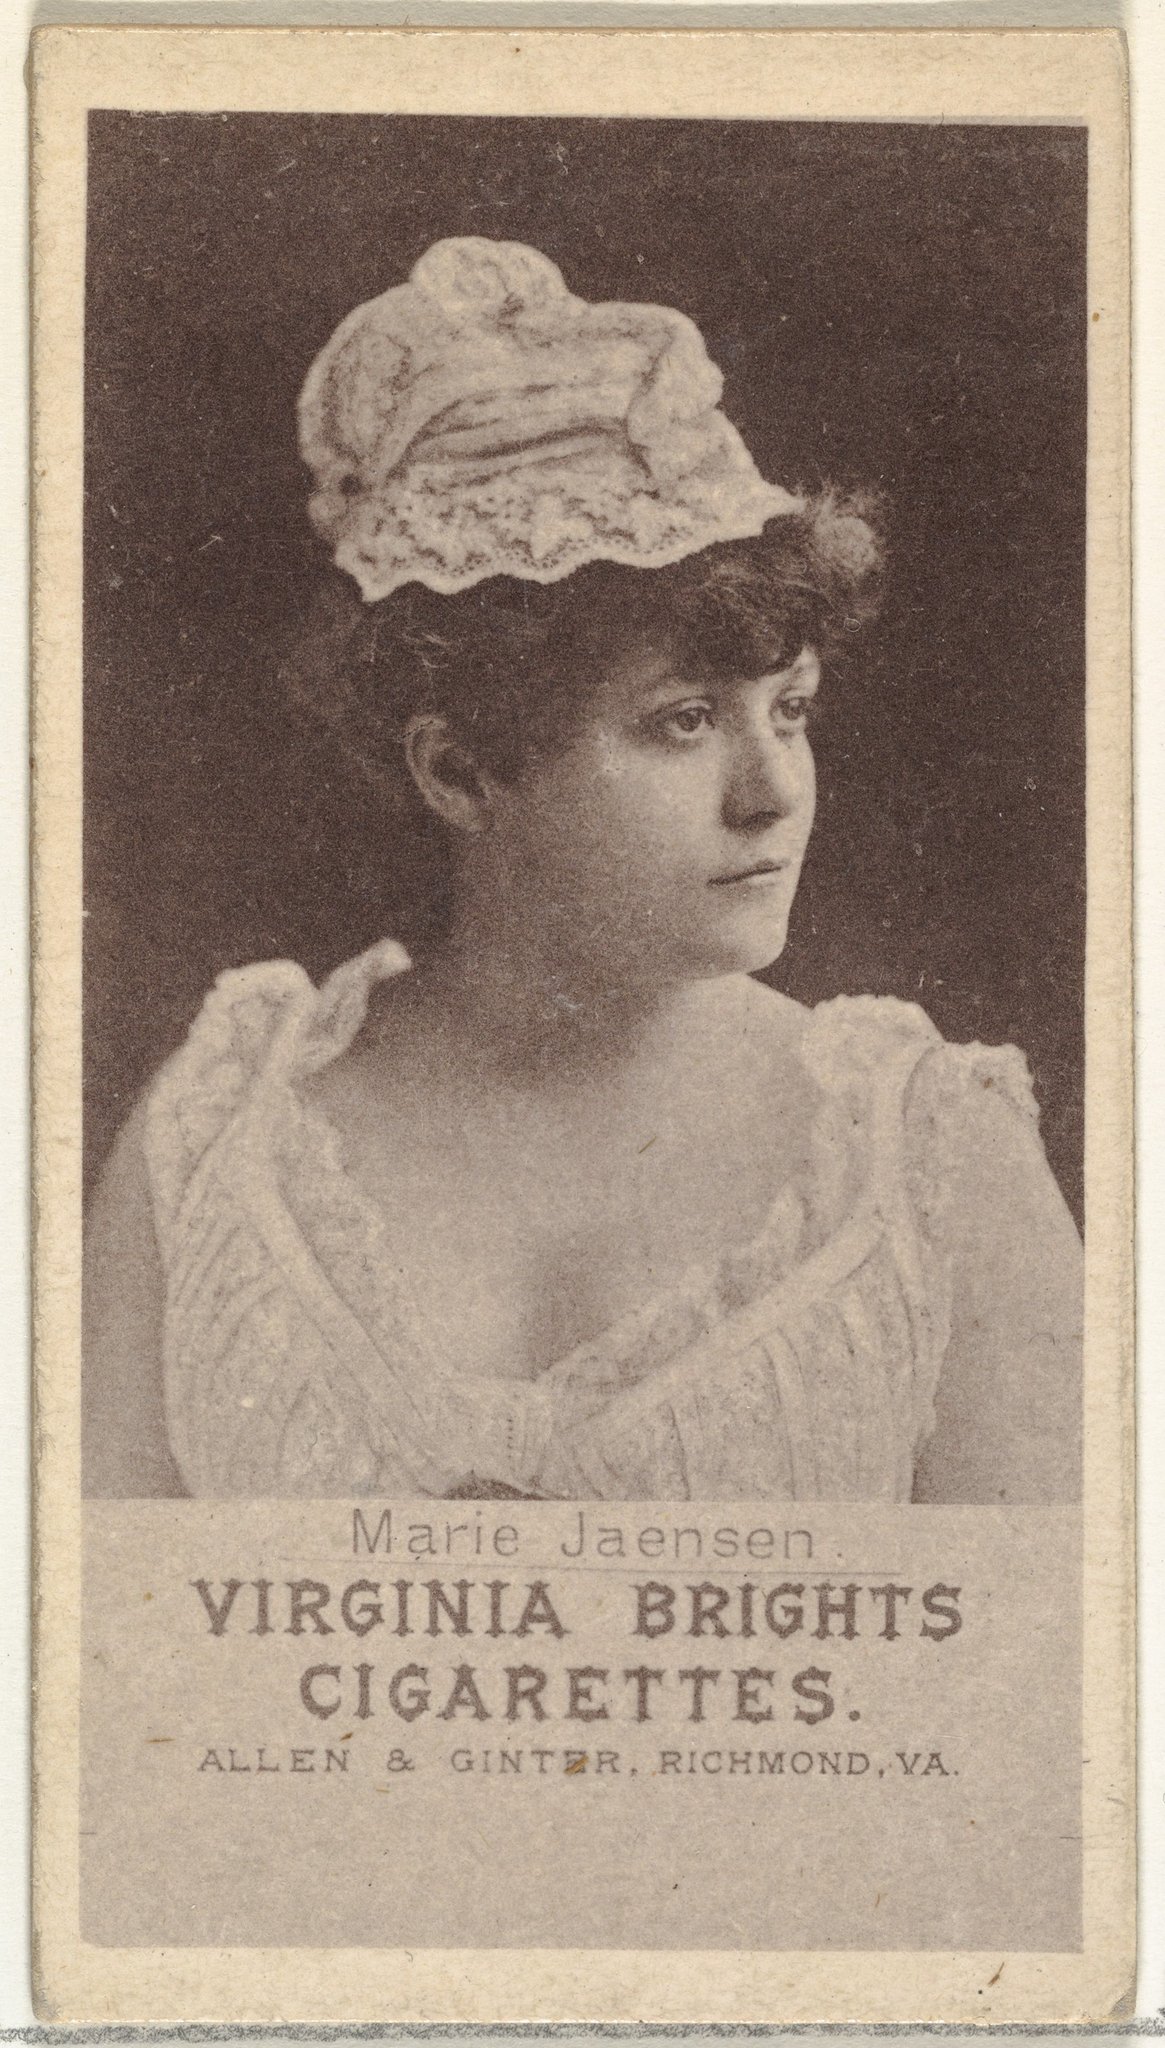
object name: print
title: Marie Jaensen, from the Actresses series (N67) promoting Virginia Brights Cigarettes for Allen & Ginter brand tobacco products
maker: allen & ginter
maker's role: publisher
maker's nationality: american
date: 1888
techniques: photolithograph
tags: portraits,women,actresses